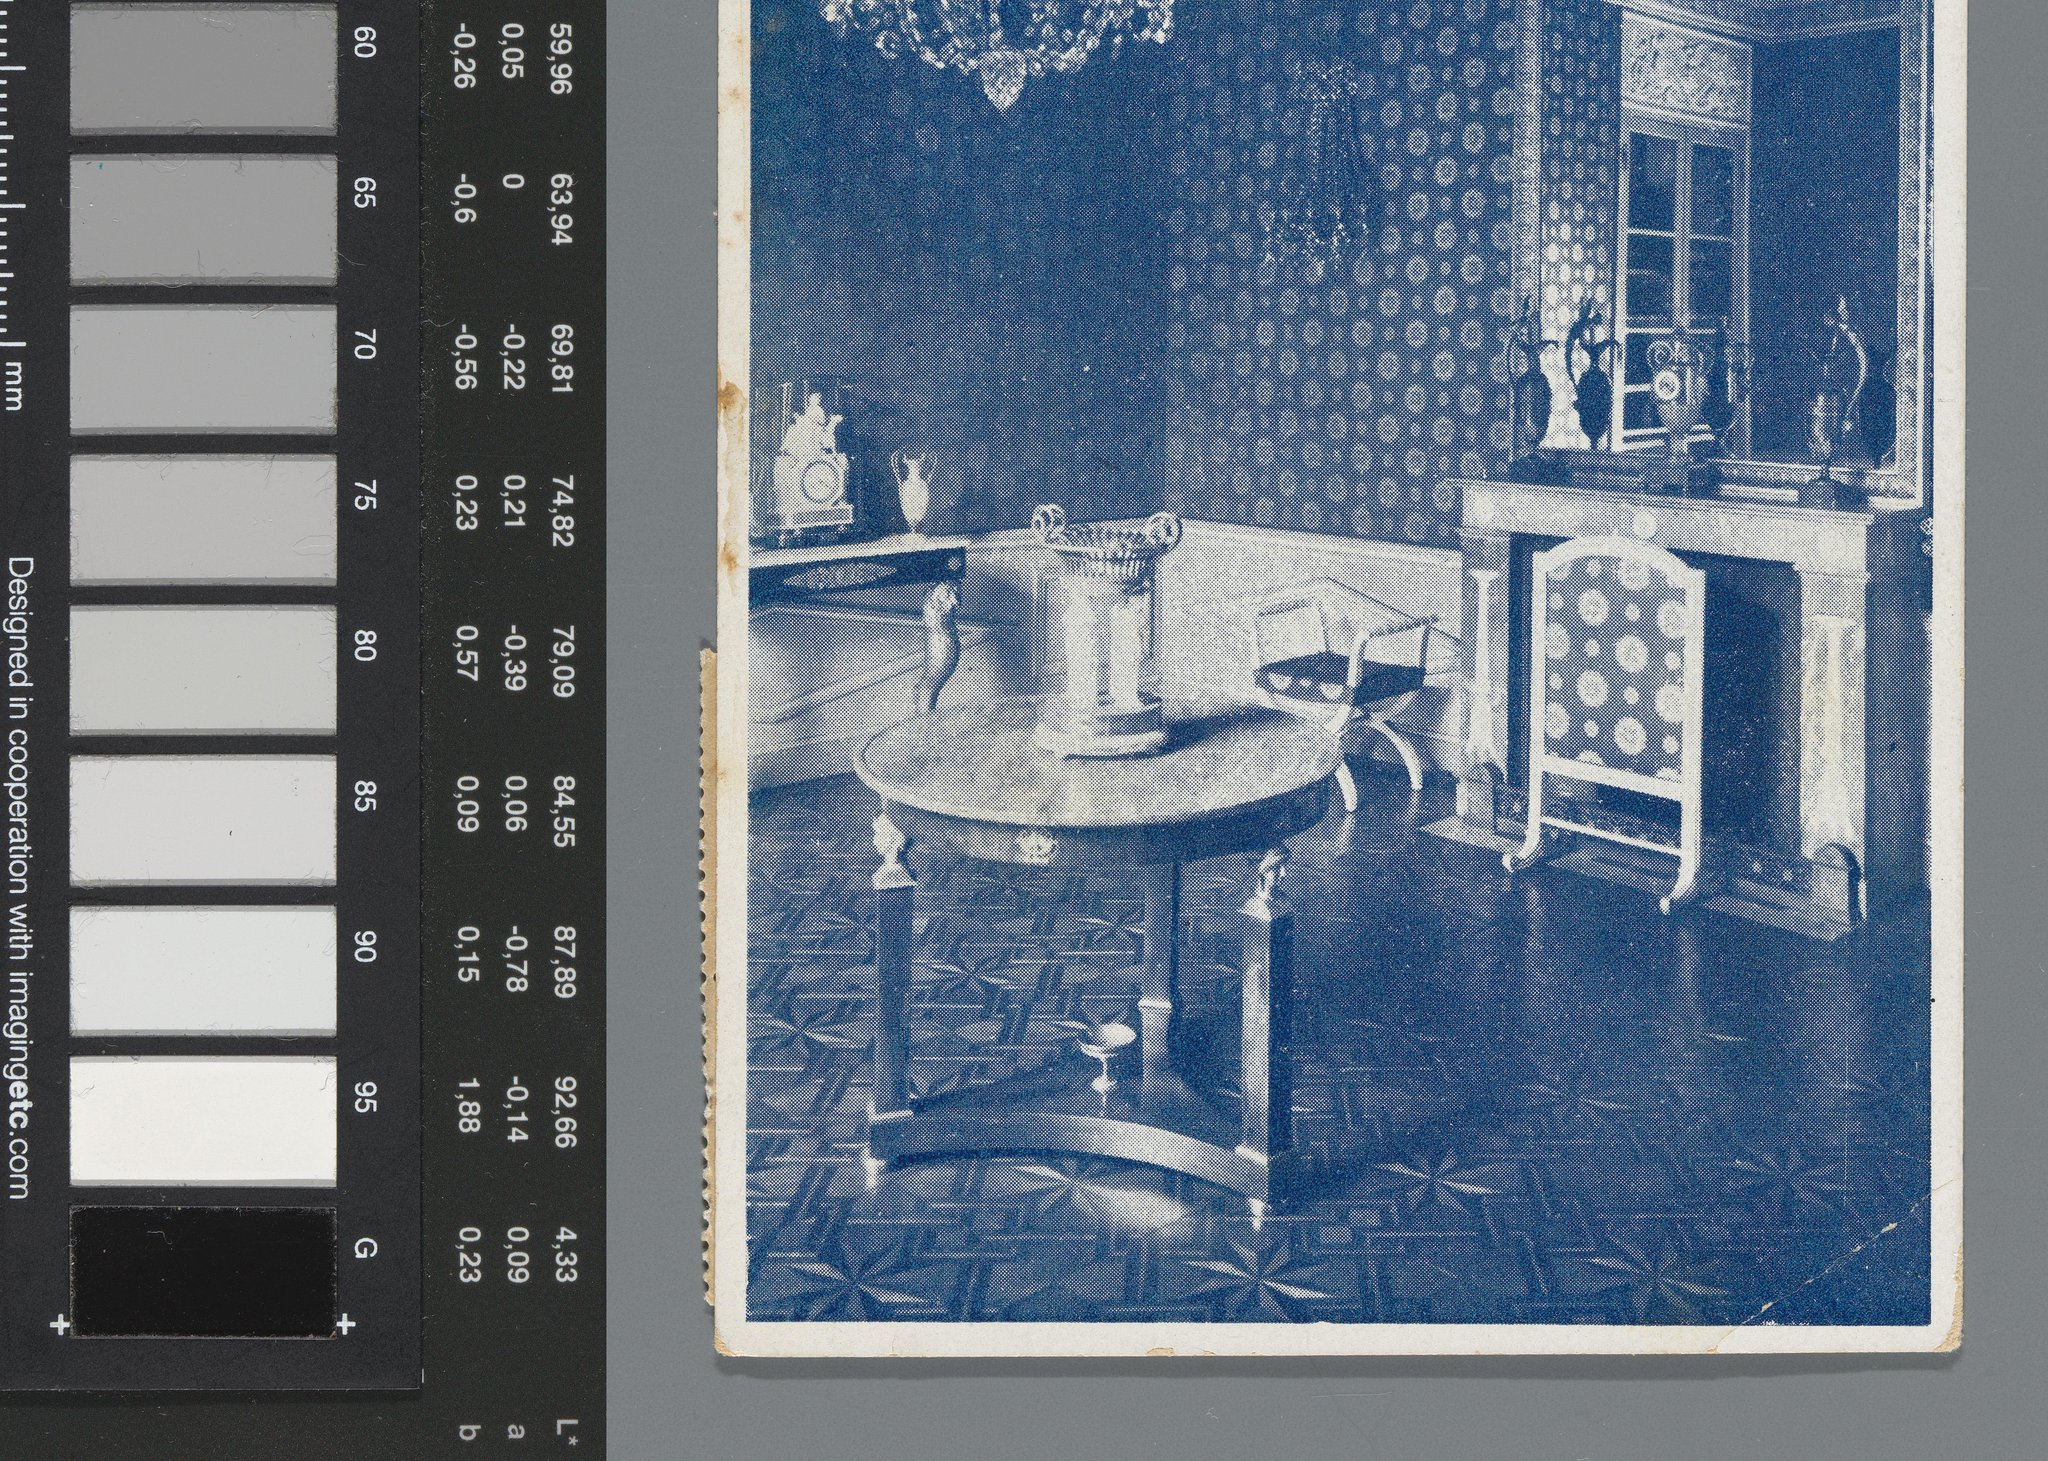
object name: postcard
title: Bibliotheque Marmottan, Le Petit Salon Bleu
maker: Anonymous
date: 1920-1950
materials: photographic support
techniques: autotype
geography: paris